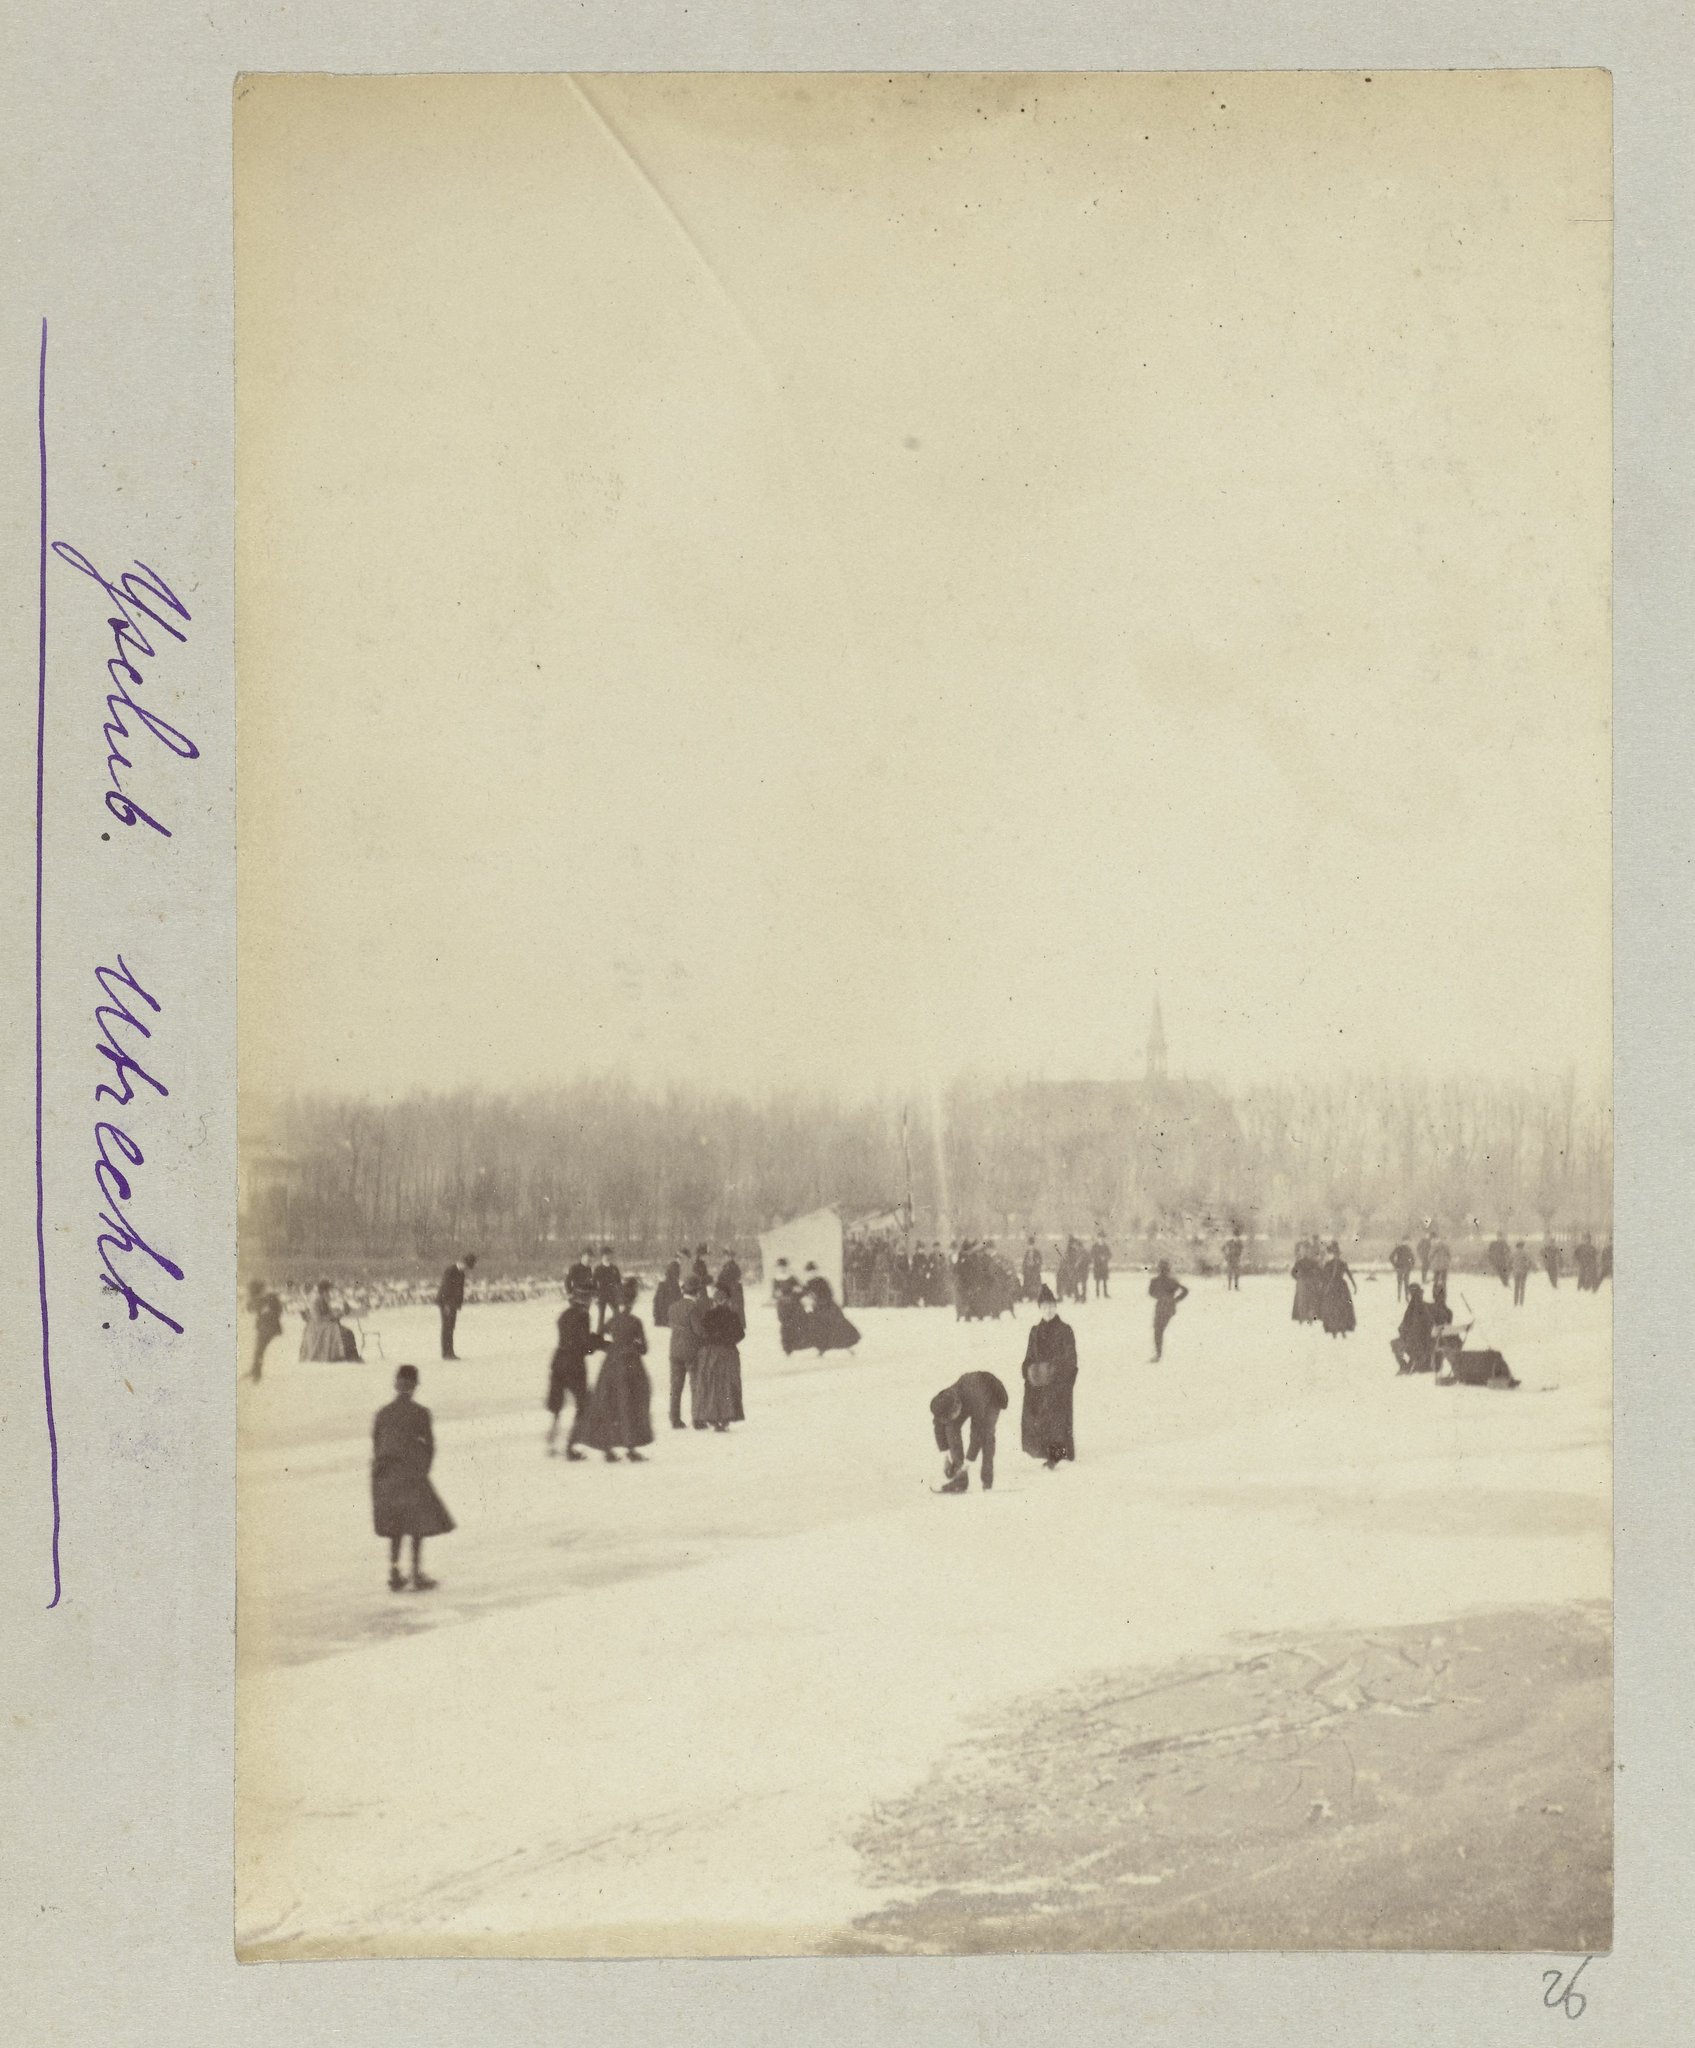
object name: photograph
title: Schaatsende mensen op het ijs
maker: henry pauw van wieldrecht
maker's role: fotograaf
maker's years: 1863-1912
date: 1888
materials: paper, photographic support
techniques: albumen print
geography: netherlands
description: Schaatsende mensen op het ijs bij ijsclub Utrecht. Met onderschrift: IJsclub Utrecht.